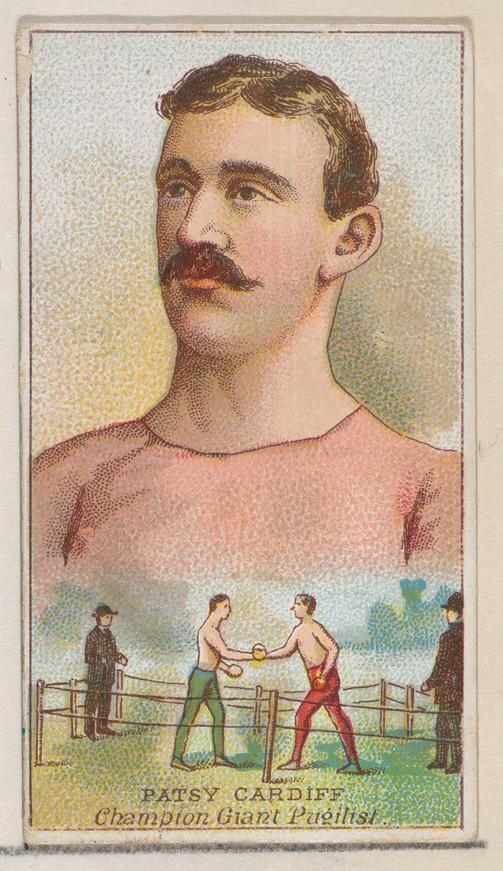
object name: print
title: Patsy Cardiff, Champion Giant Pugilist, from the Champions of Games and Sports series (N184, Type 2) issued by W.S. Kimball & Co.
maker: w.s. kimball & co.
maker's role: publisher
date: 1887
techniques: color lithograph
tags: men,boxing,athletes